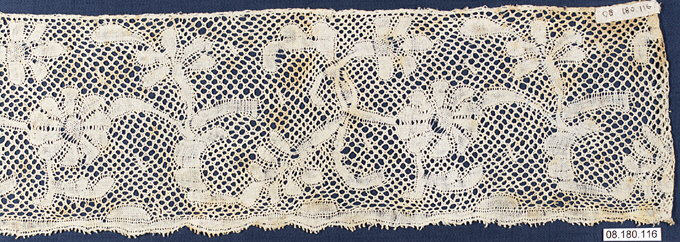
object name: fragment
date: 1601-1700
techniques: lace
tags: flowers